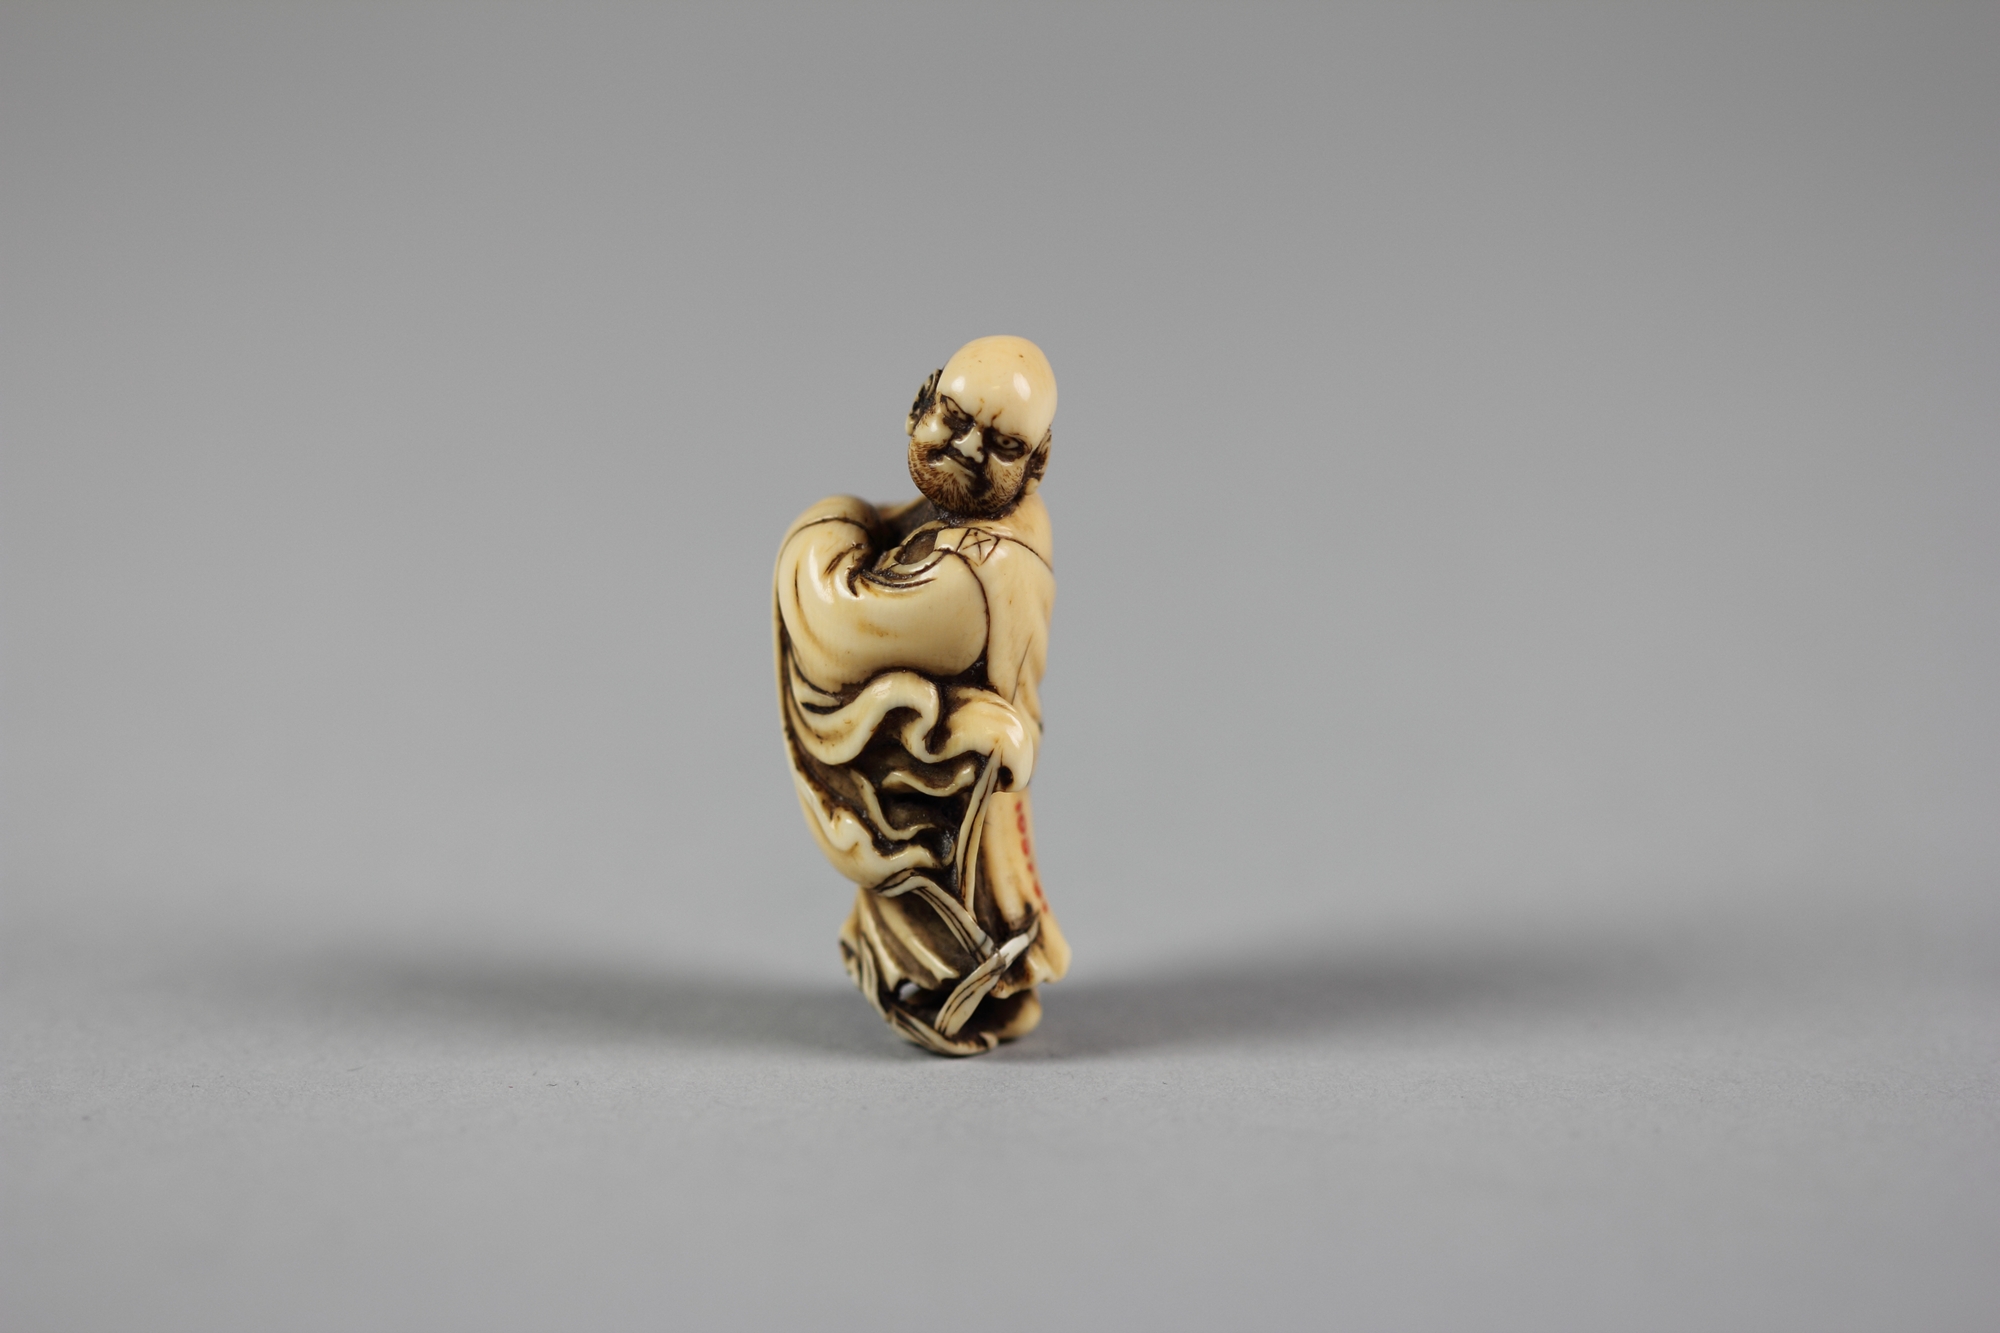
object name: netsuke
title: Netsuke of Daruma Crossing the Yangzi River on a Reed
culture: japanese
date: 1801-1900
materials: ivory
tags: men